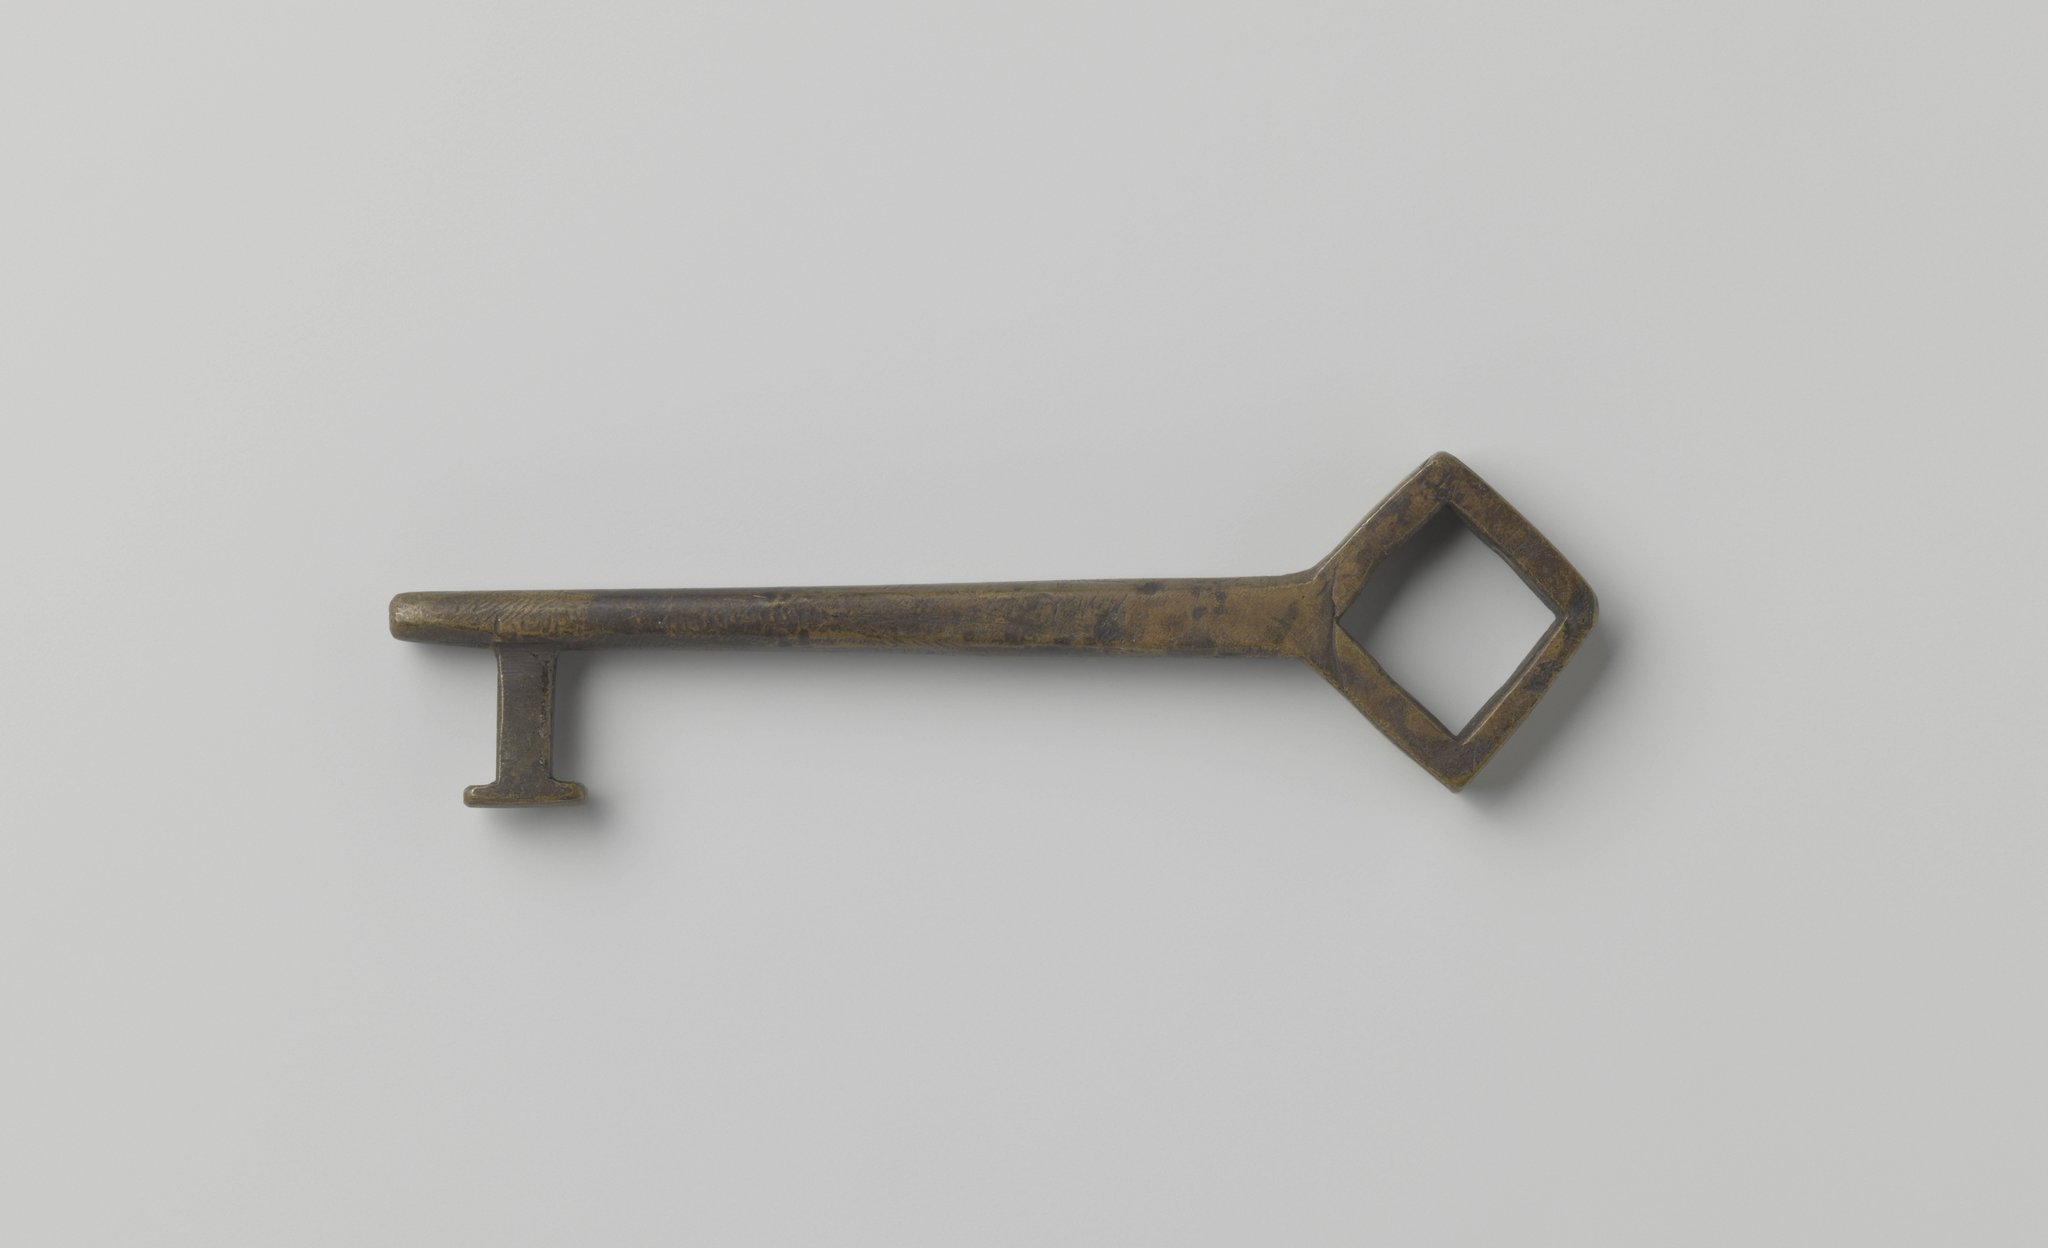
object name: key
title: Sleutel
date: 1400-1950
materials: bronze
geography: oosters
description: Sleutel met ruitvormig oog, lange, zich naar onderen verdunnende schacht en t-vormige baard.